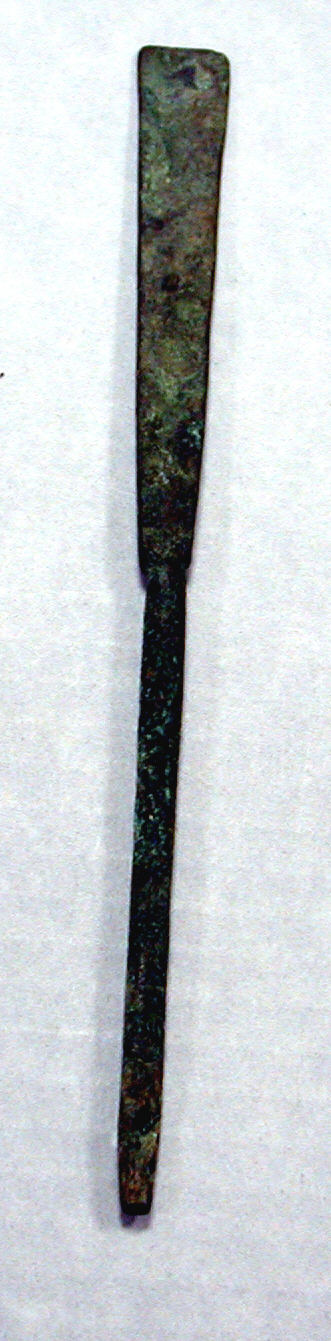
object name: chisel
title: Hammered Copper Chisel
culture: peruvian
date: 1-1566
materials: copper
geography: peru